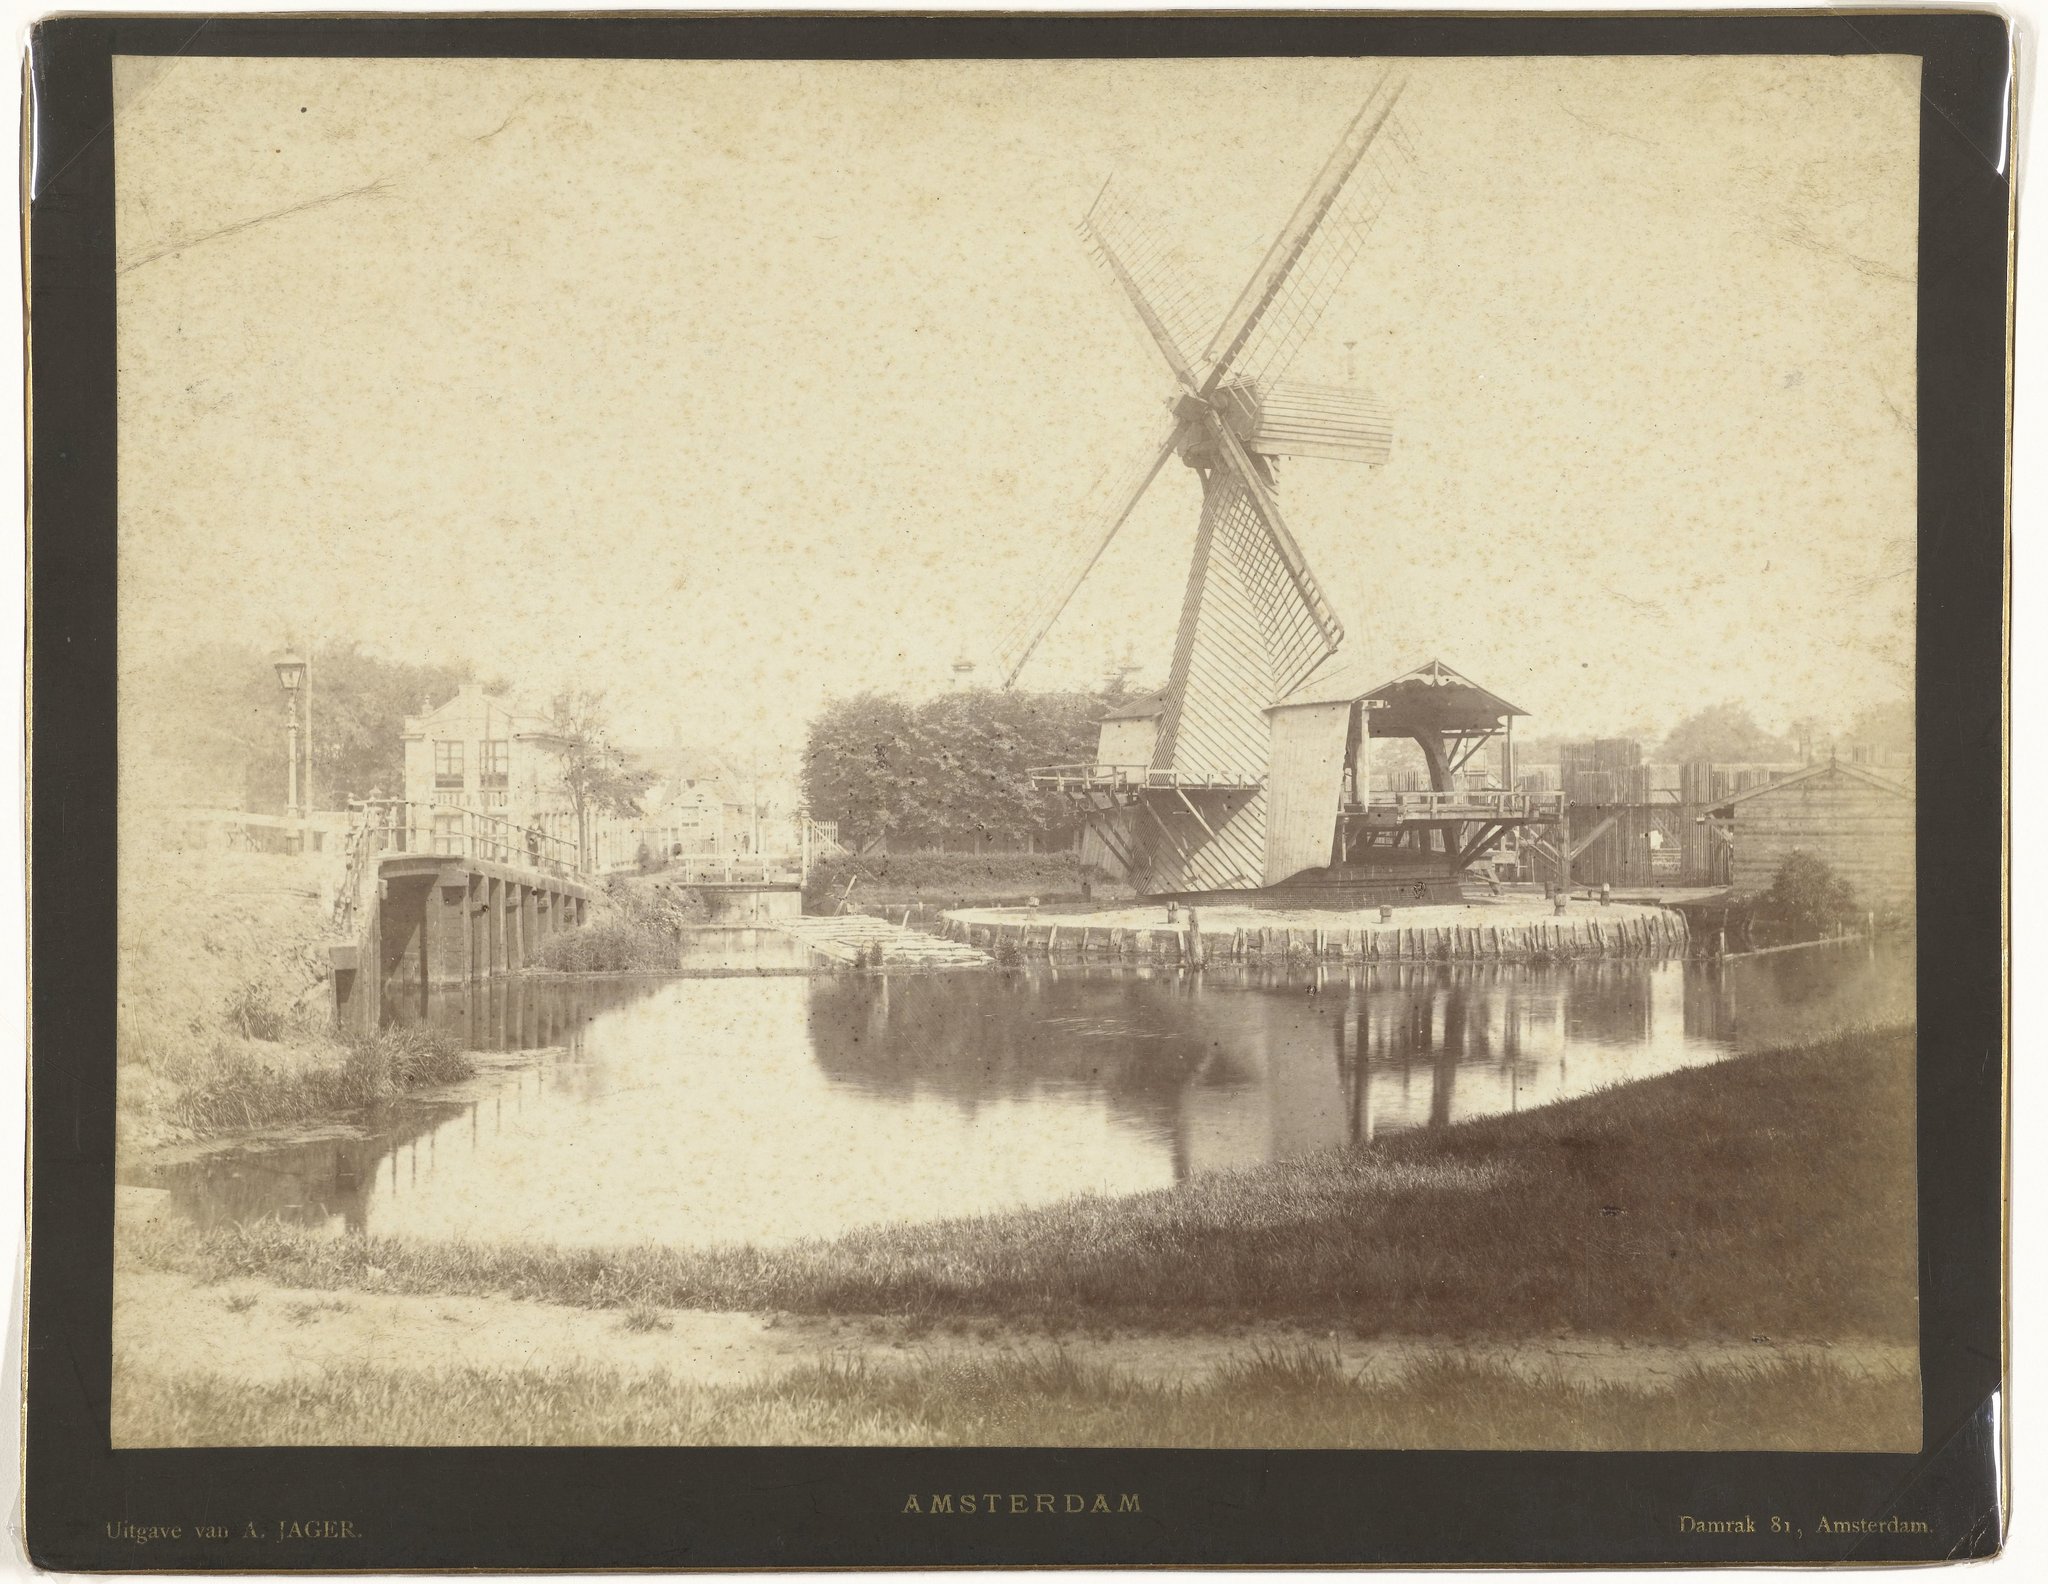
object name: photograph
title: Amsterdam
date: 1880-1900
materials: paper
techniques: albumen print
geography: netherlands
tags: saw-mill (works), amsterdam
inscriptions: signature: ‘Amsterdam, Uitgave van A. Jager, Damrak 81, Amsterdam’, annotation: ‘Buiten de zaagmolenpoort in A'dam west ter hoogte van Oldebarneveltstraat . De Zaagmolenpoort was niet meer dan een doorgang door de stadwal en is gesloopt in 1844’